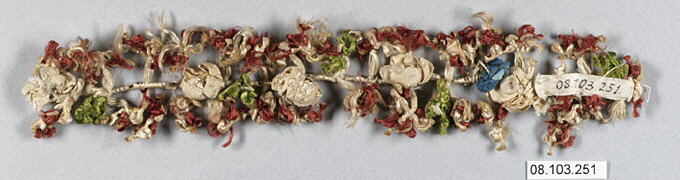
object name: gimp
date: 1750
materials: silk